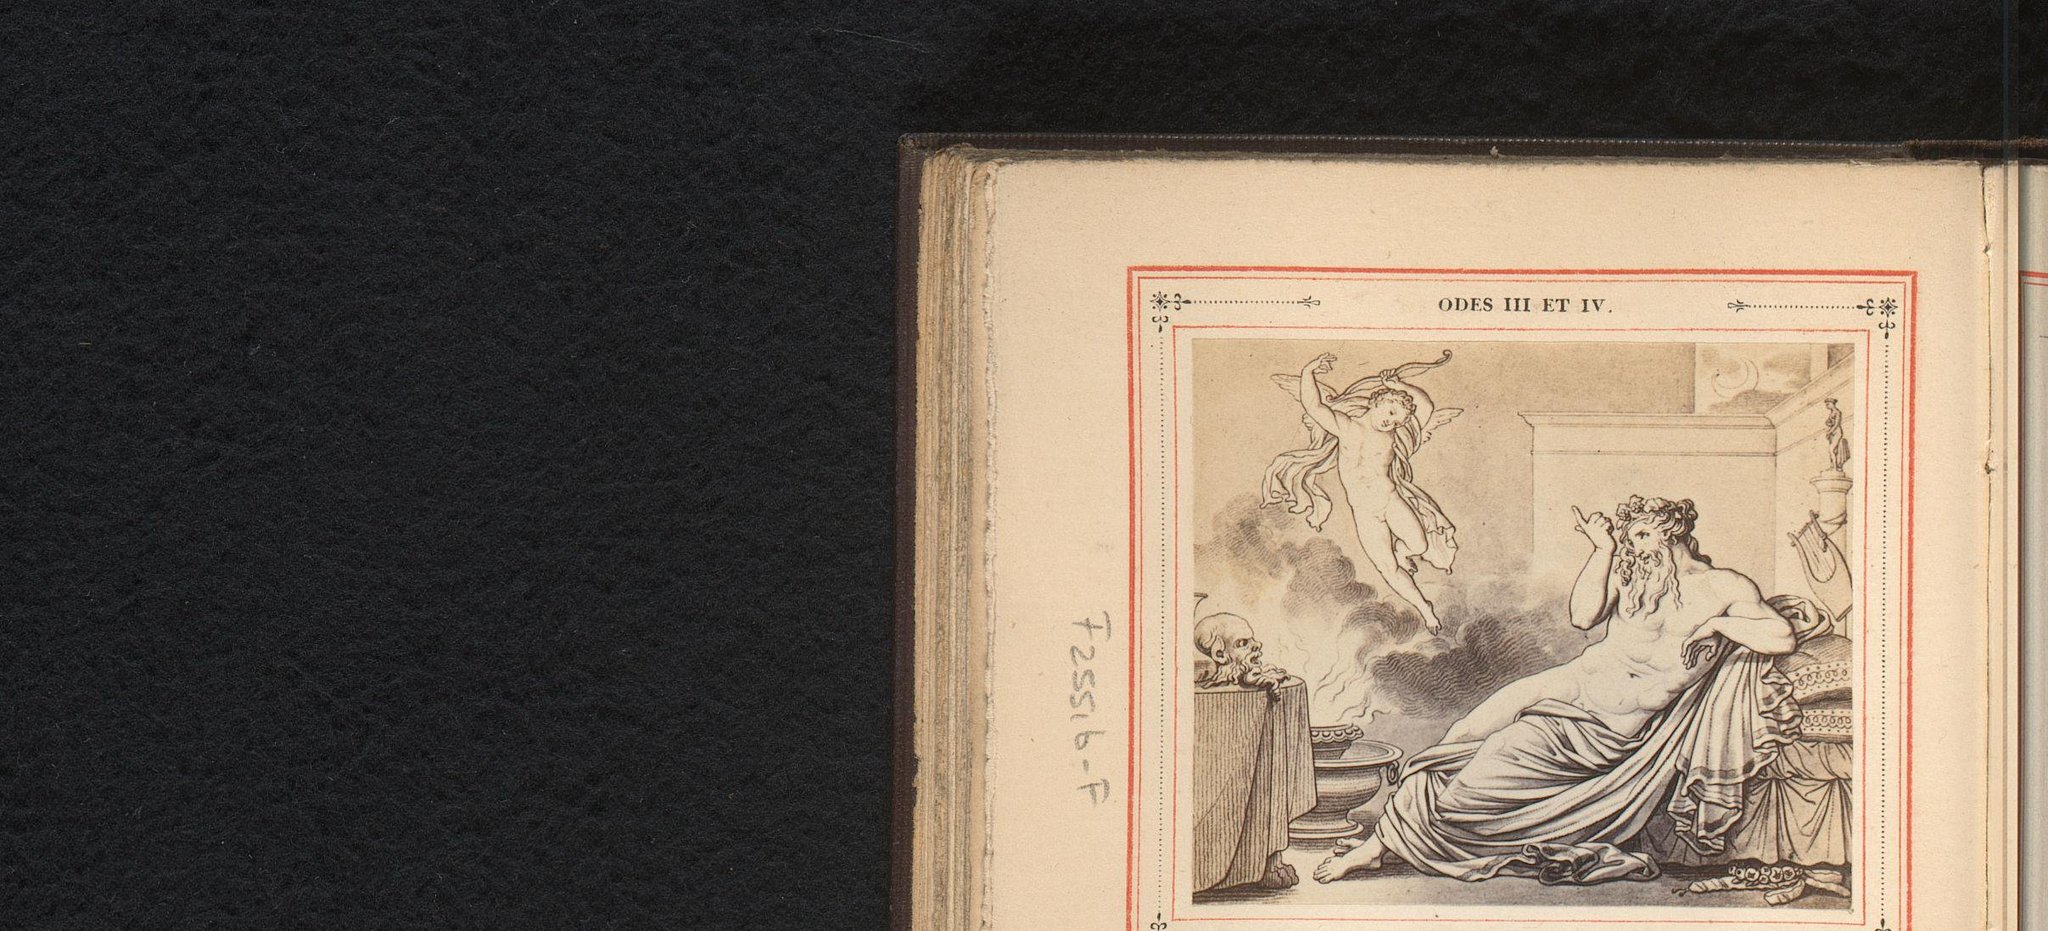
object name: reproduction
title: Fotoreproductie van een tekening van Girodet, god met engel, illustratie bij Apothéose d'Anacréon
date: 1859-1864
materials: paper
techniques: albumen print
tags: gods ~ classical mythology